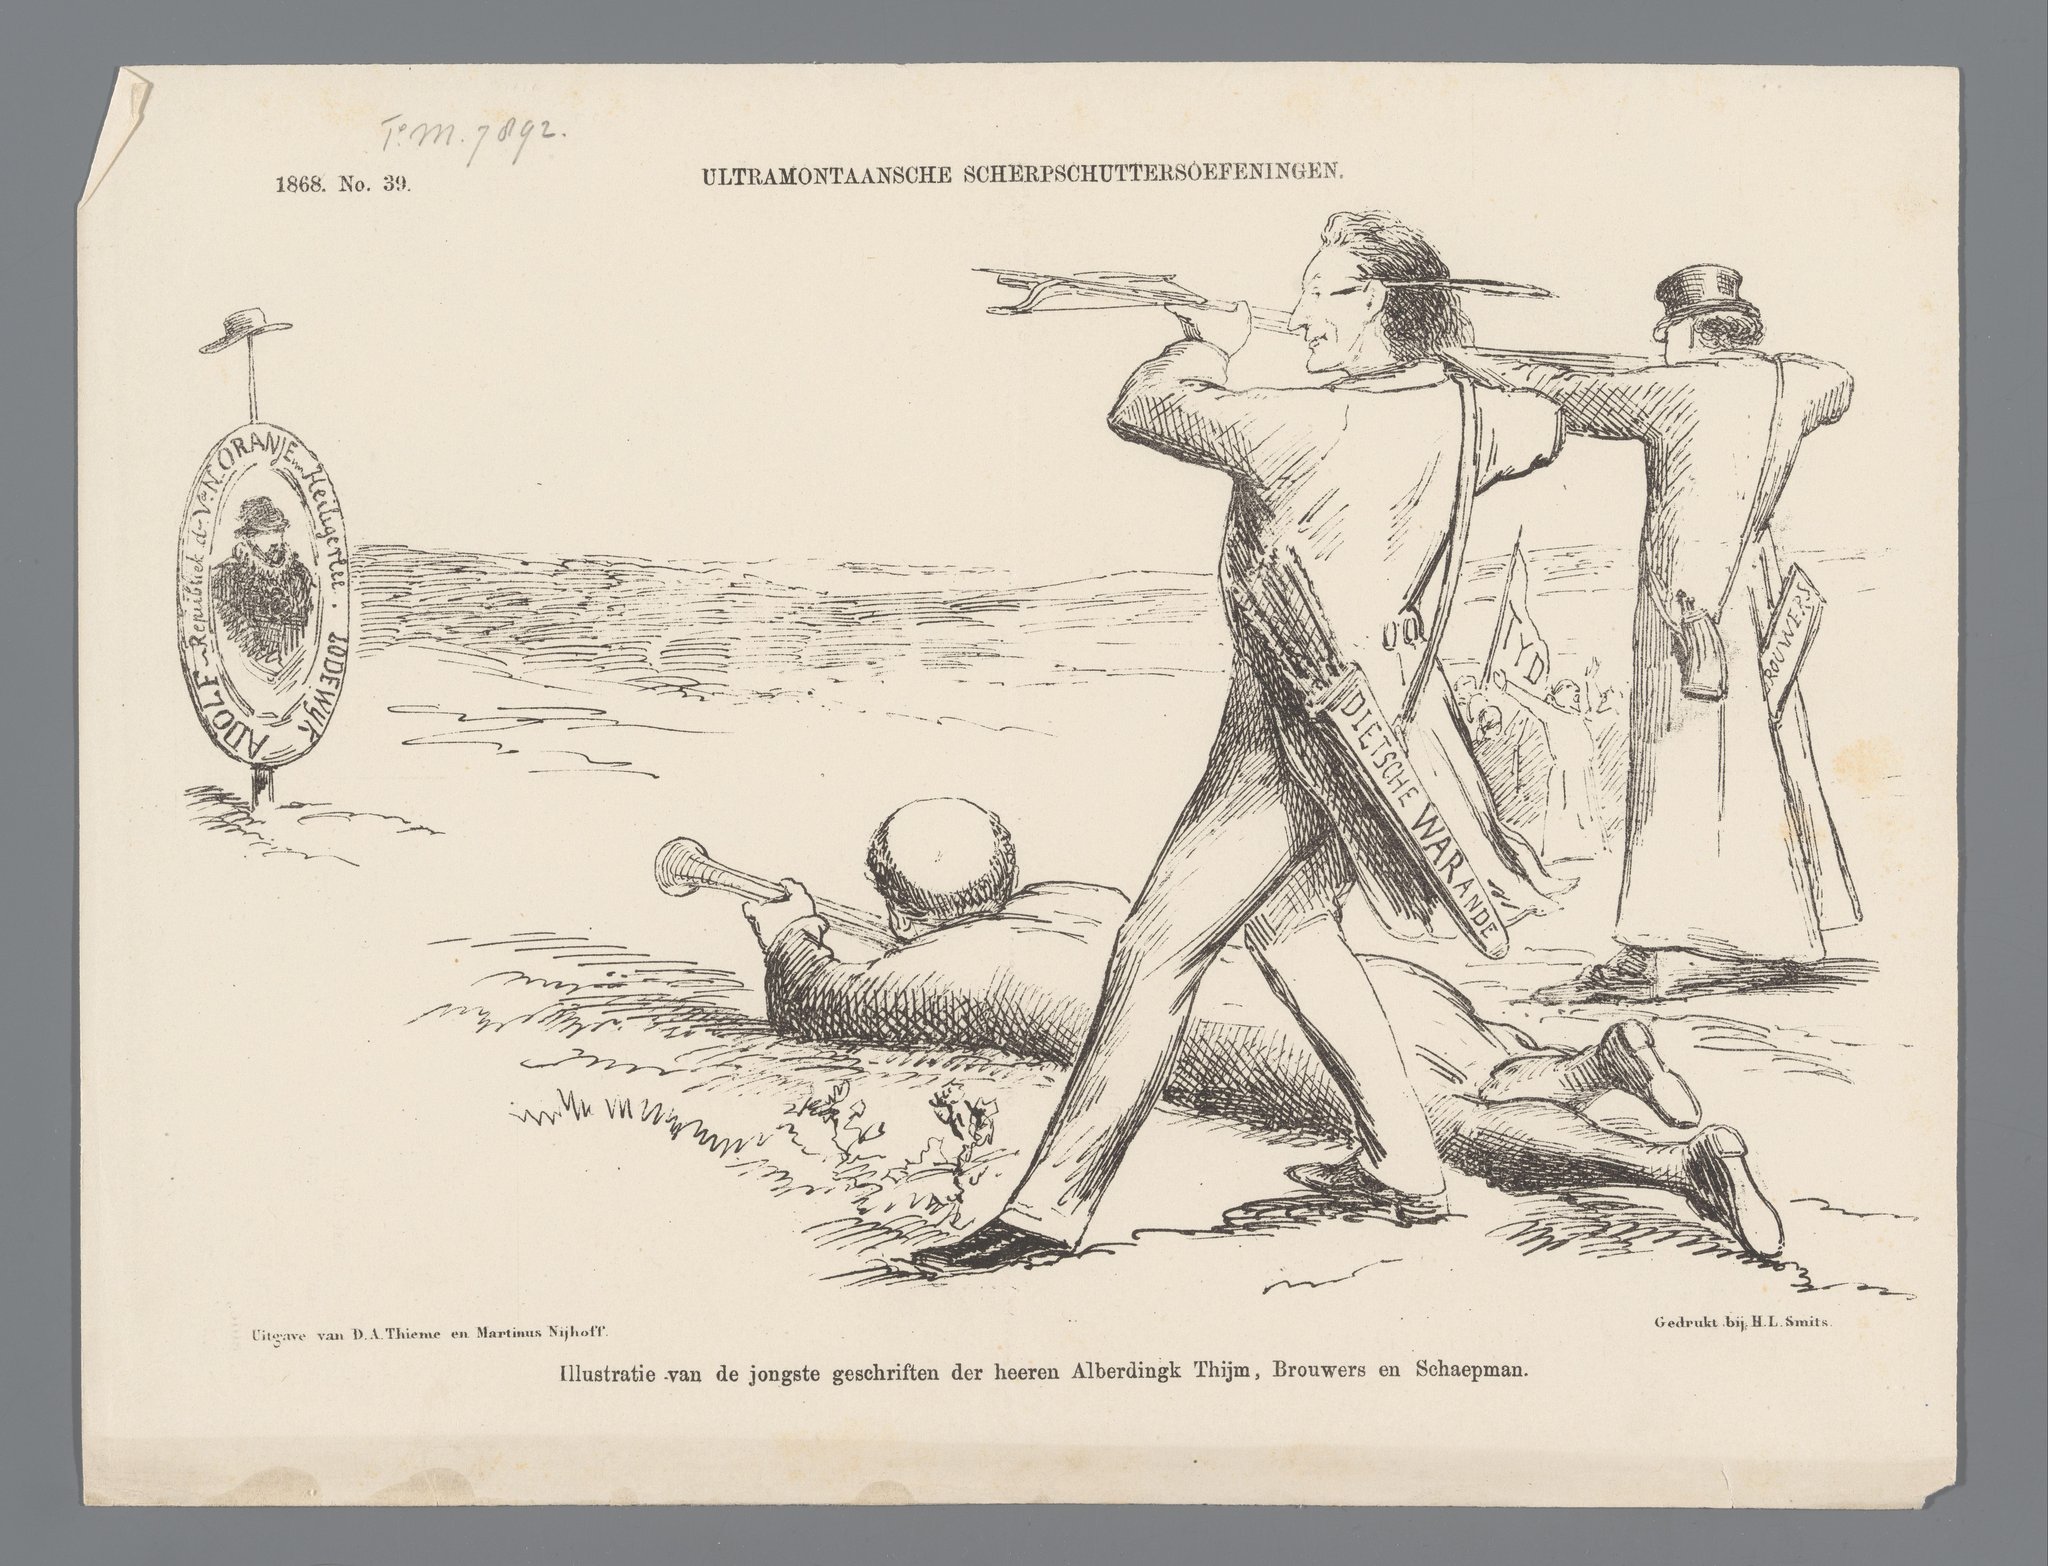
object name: cartoon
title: Ultramontaansche scherpschuttersoefeningen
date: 1867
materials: paper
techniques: lithograph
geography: the hague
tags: rome, priest, herman johannes aloysius maria schaepman, delft, william i (prince of orange), amsterdam, painter, draughtsman, publisher, josephus albertus alberdingk thijm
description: Spotprent op de ultramontaanse protesten tegen de viering van de Slag bij Heiligerlee. Alberdingk Thijm, abt Brouwers en Schaepman schieten op een portret van Willem van Oranje. Plaat verschenen bij het weekblad De Nederlandsche Spectator, nr. 39, 26 september 1868.